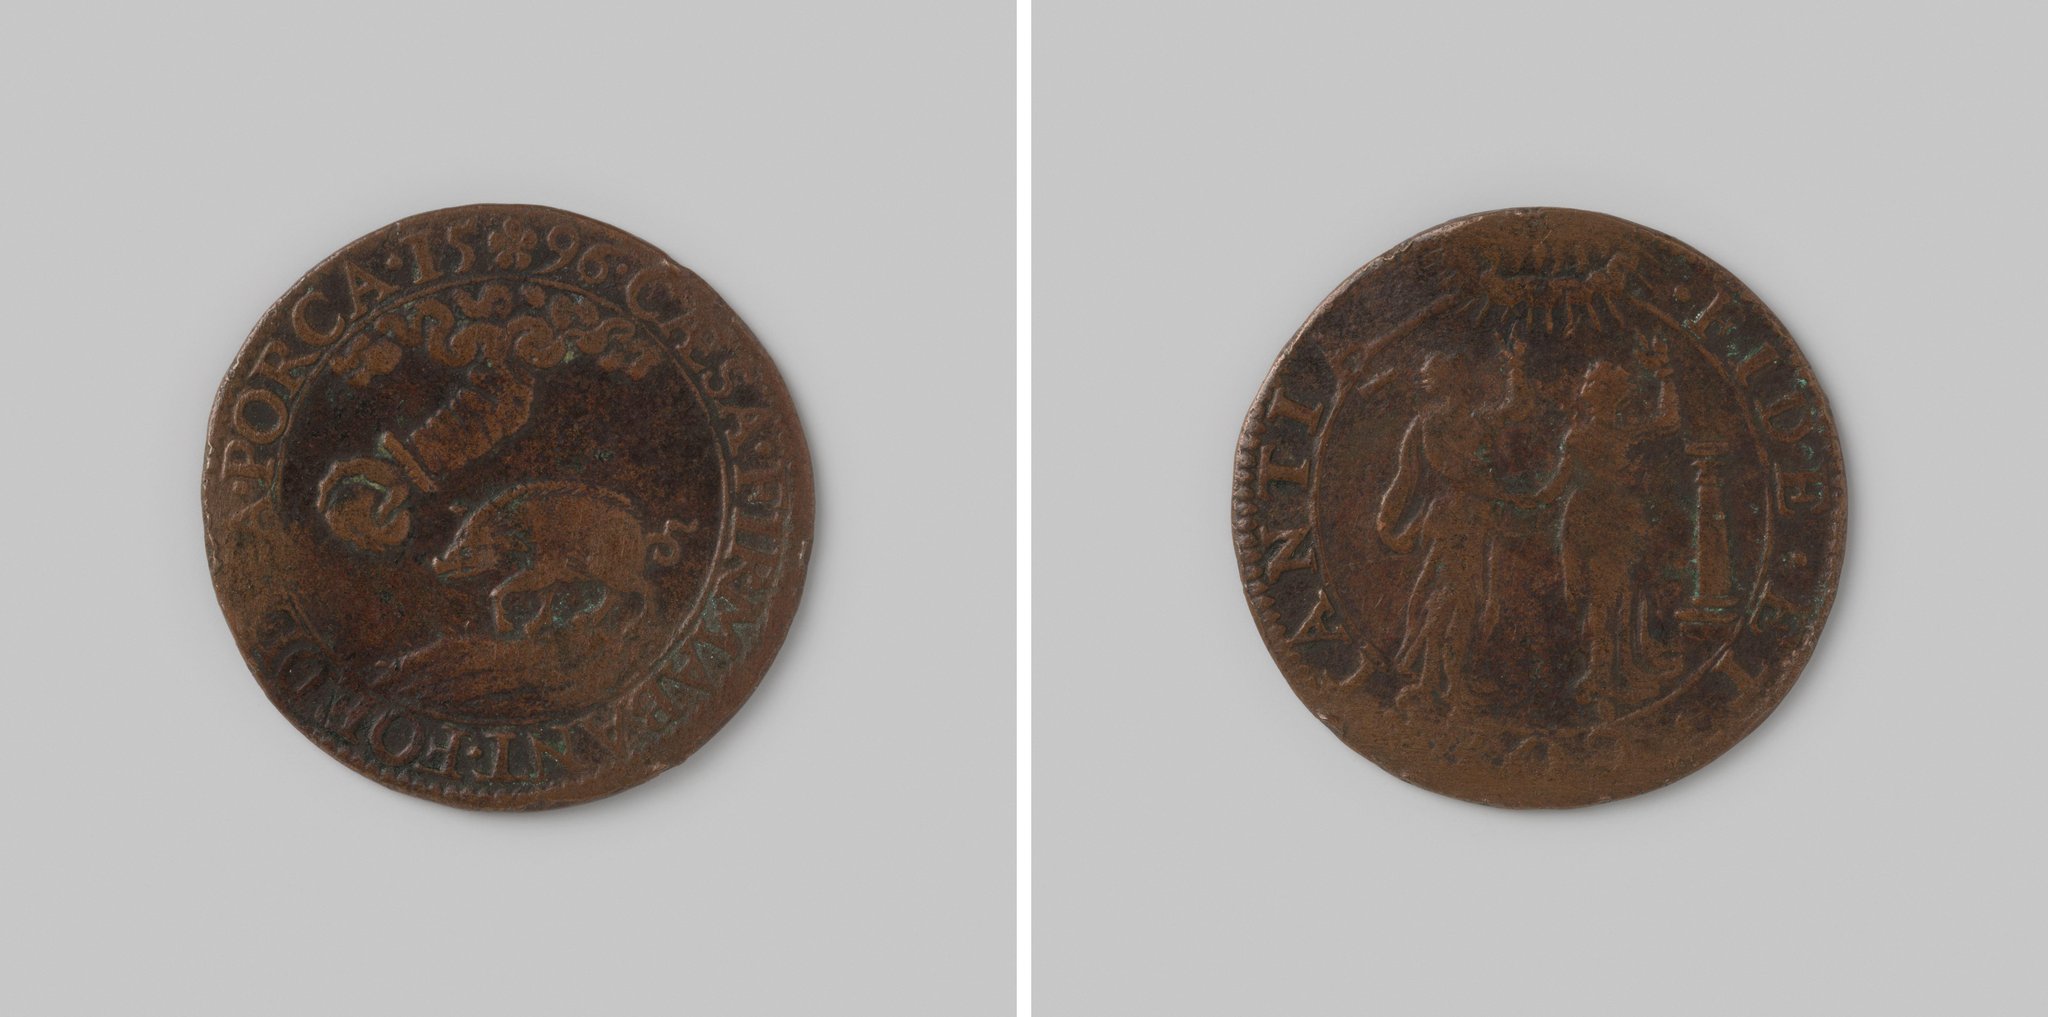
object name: history medal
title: Rekenpenning uit Dordrecht op het Drievoudig Verbond tussen Frankrijk Engeland en Nederland 1596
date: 1596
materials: copper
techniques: striking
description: Koperen penning, op de voorzijde een hand uit de wolken die met een steen een zwijn bedreigt, met omschrift, op de keerzijde Geloof en Standvastigheid elkaar de hand schuddend onder de stralende naam Gods, met omschrift.